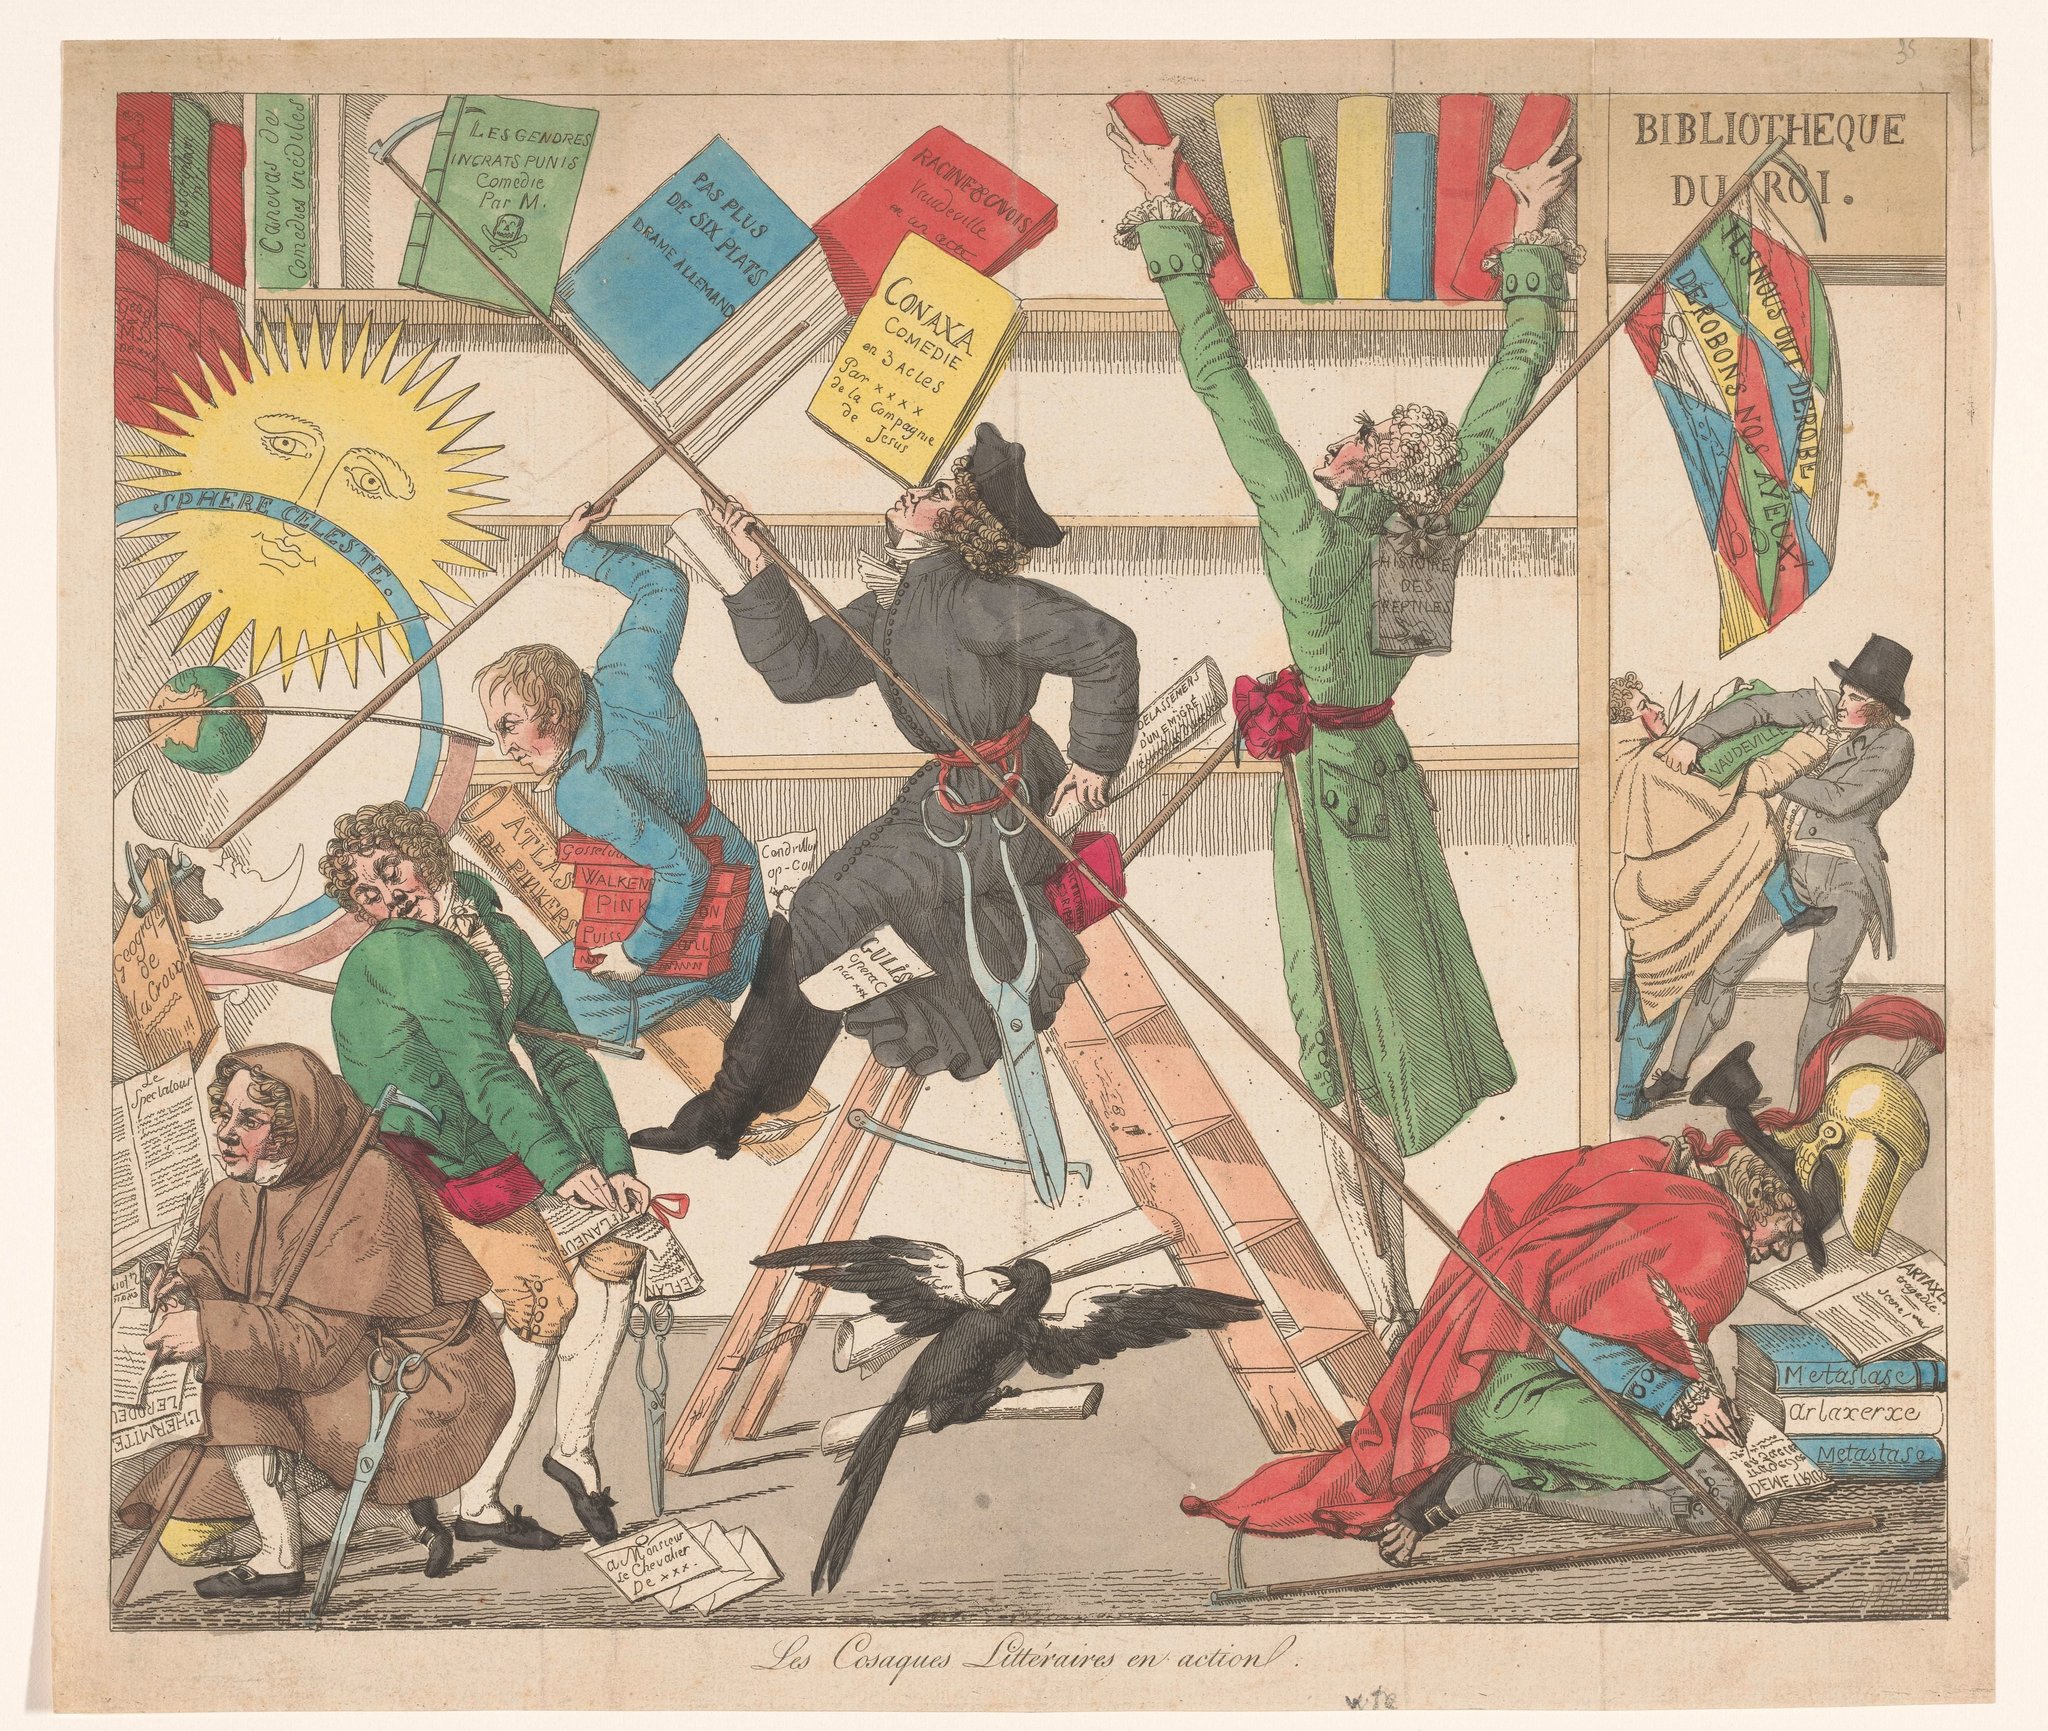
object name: print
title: Mannen verwijderen boeken uit de Bibliothèque du Roi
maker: Anonymous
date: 1775-1800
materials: paper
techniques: etching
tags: bookshelves, plunder of the arts, armillary sphere, skeleton celestial globe, public library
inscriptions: collector's mark: Lugt 2228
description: Zes mannen met enterhaken verwijderen boeken van de planken in de Bibliothèque du Roi. Drie van hen dragen scharen om hun middel en een van hen draagt een vlag met een schaar en de tekst: 'Ils nous ont derobe, derobons nos ayeux!' In het midden trekt een geestelijke op een trap met zijn enterhaak boeken van de plank af. Naast hem vernielt een man met geografische werken onder zijn arm met zijn enterhaak een hemelglobe. Rechts op de voorgrond is een man bezig met het overschrijven van werken van Pietro Metastasio. In de achtergrond vechten twee mannen om een boek getiteld 'Vaudeville'.